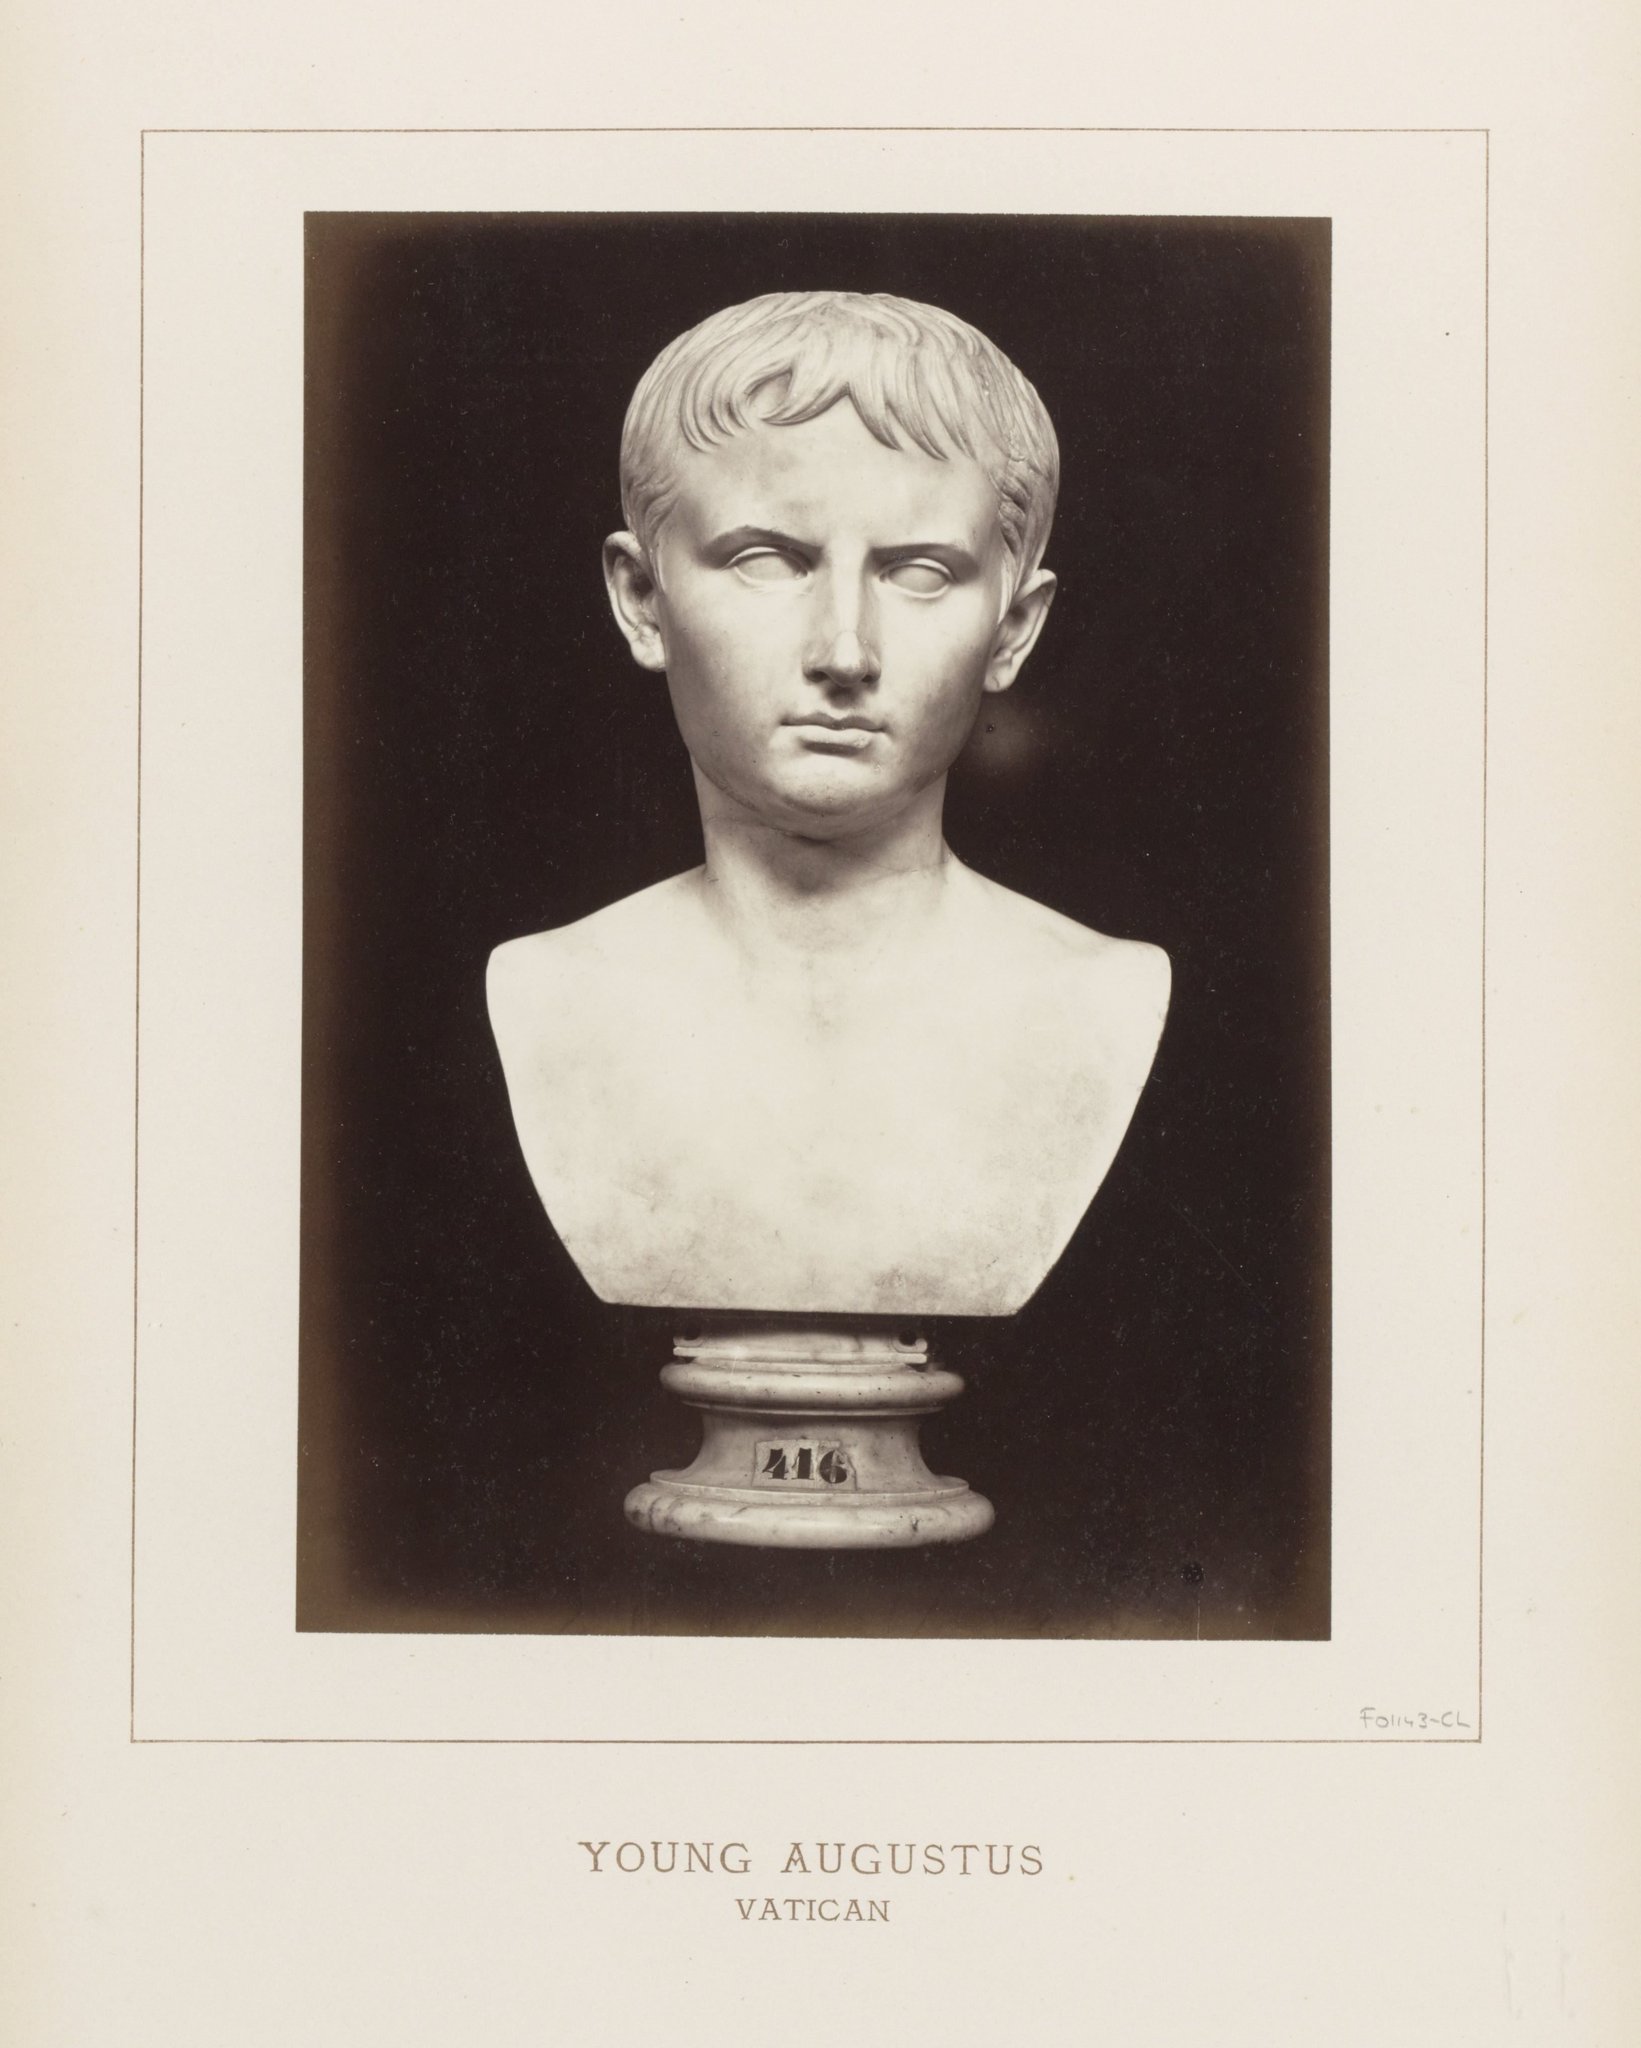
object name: photograph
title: Young Augustus, Vatican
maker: Anonymous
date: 1860-1900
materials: photographic support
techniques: albumen print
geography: vatican city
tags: piece of sculpture, reproduction of a piece of sculpture, ruler, sovereign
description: Onderdeel van Fotoalbum met opnames van bezienswaardigheden en kunstwerken in Rome.